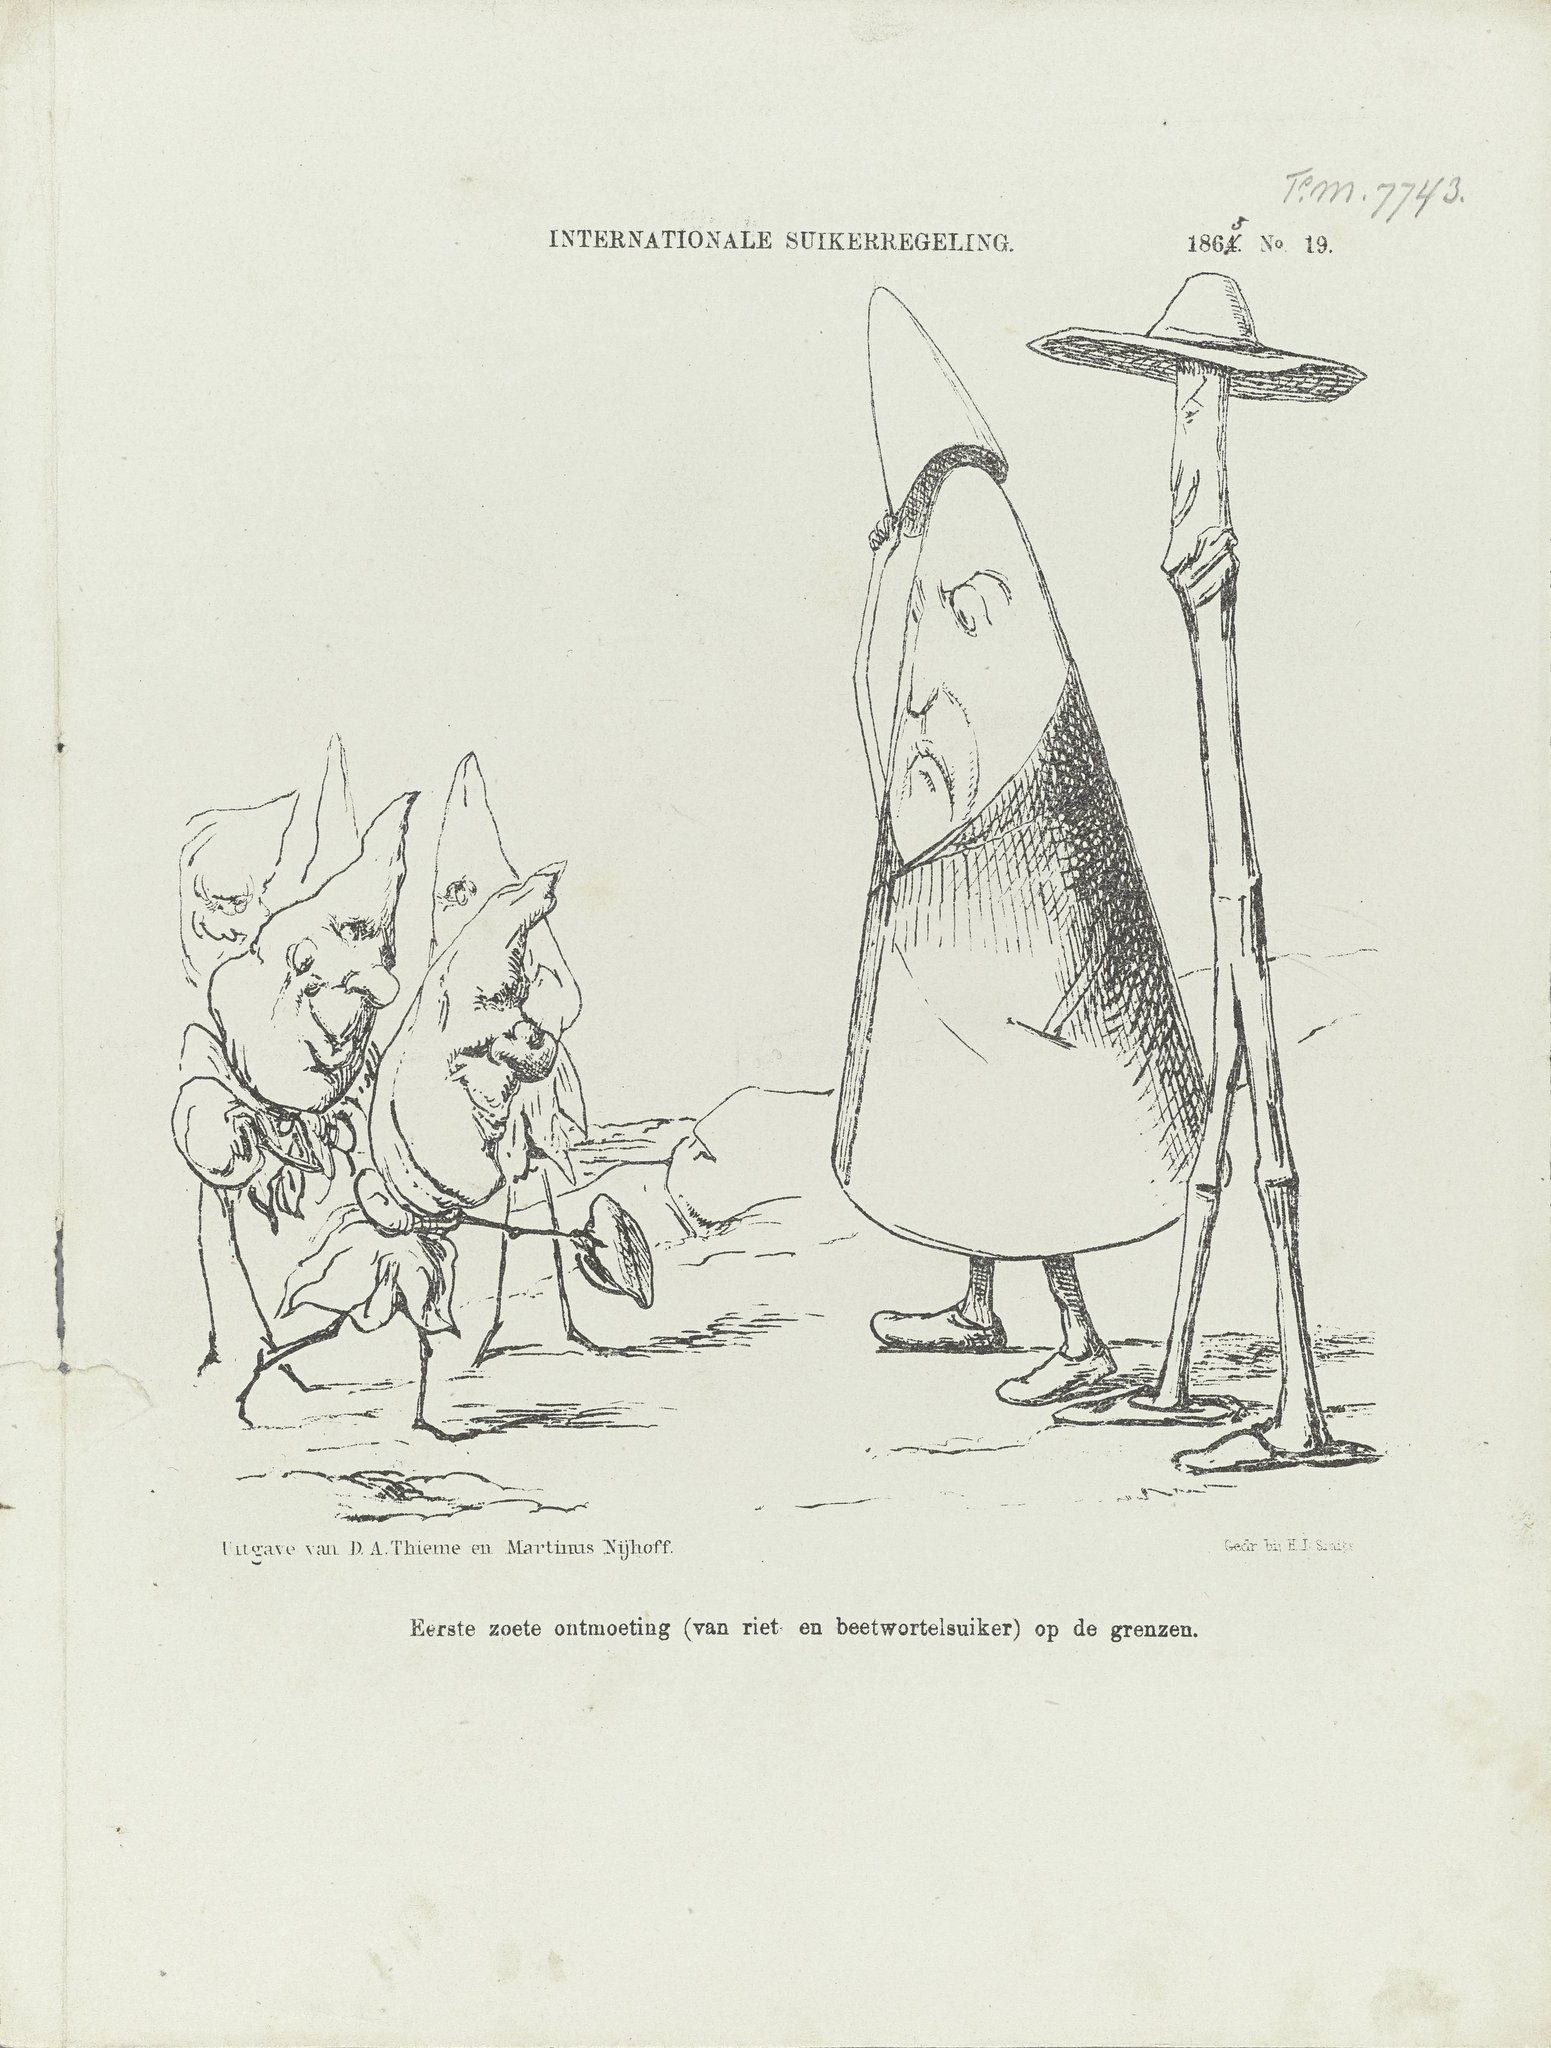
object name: print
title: Spotprent op de suikerindustrie, 1865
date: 1865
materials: paper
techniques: lithograph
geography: the hague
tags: sugar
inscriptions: collector's mark: Lugt 2228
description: Spotprent op de suikerindustrie. Een suikerbrood en een stengel rietsuiker ontmoeten een groep suikerbieten. Plaat verschenen bij het weekblad De Nederlandsche Spectator, nr. 19, 13 mei 1865.